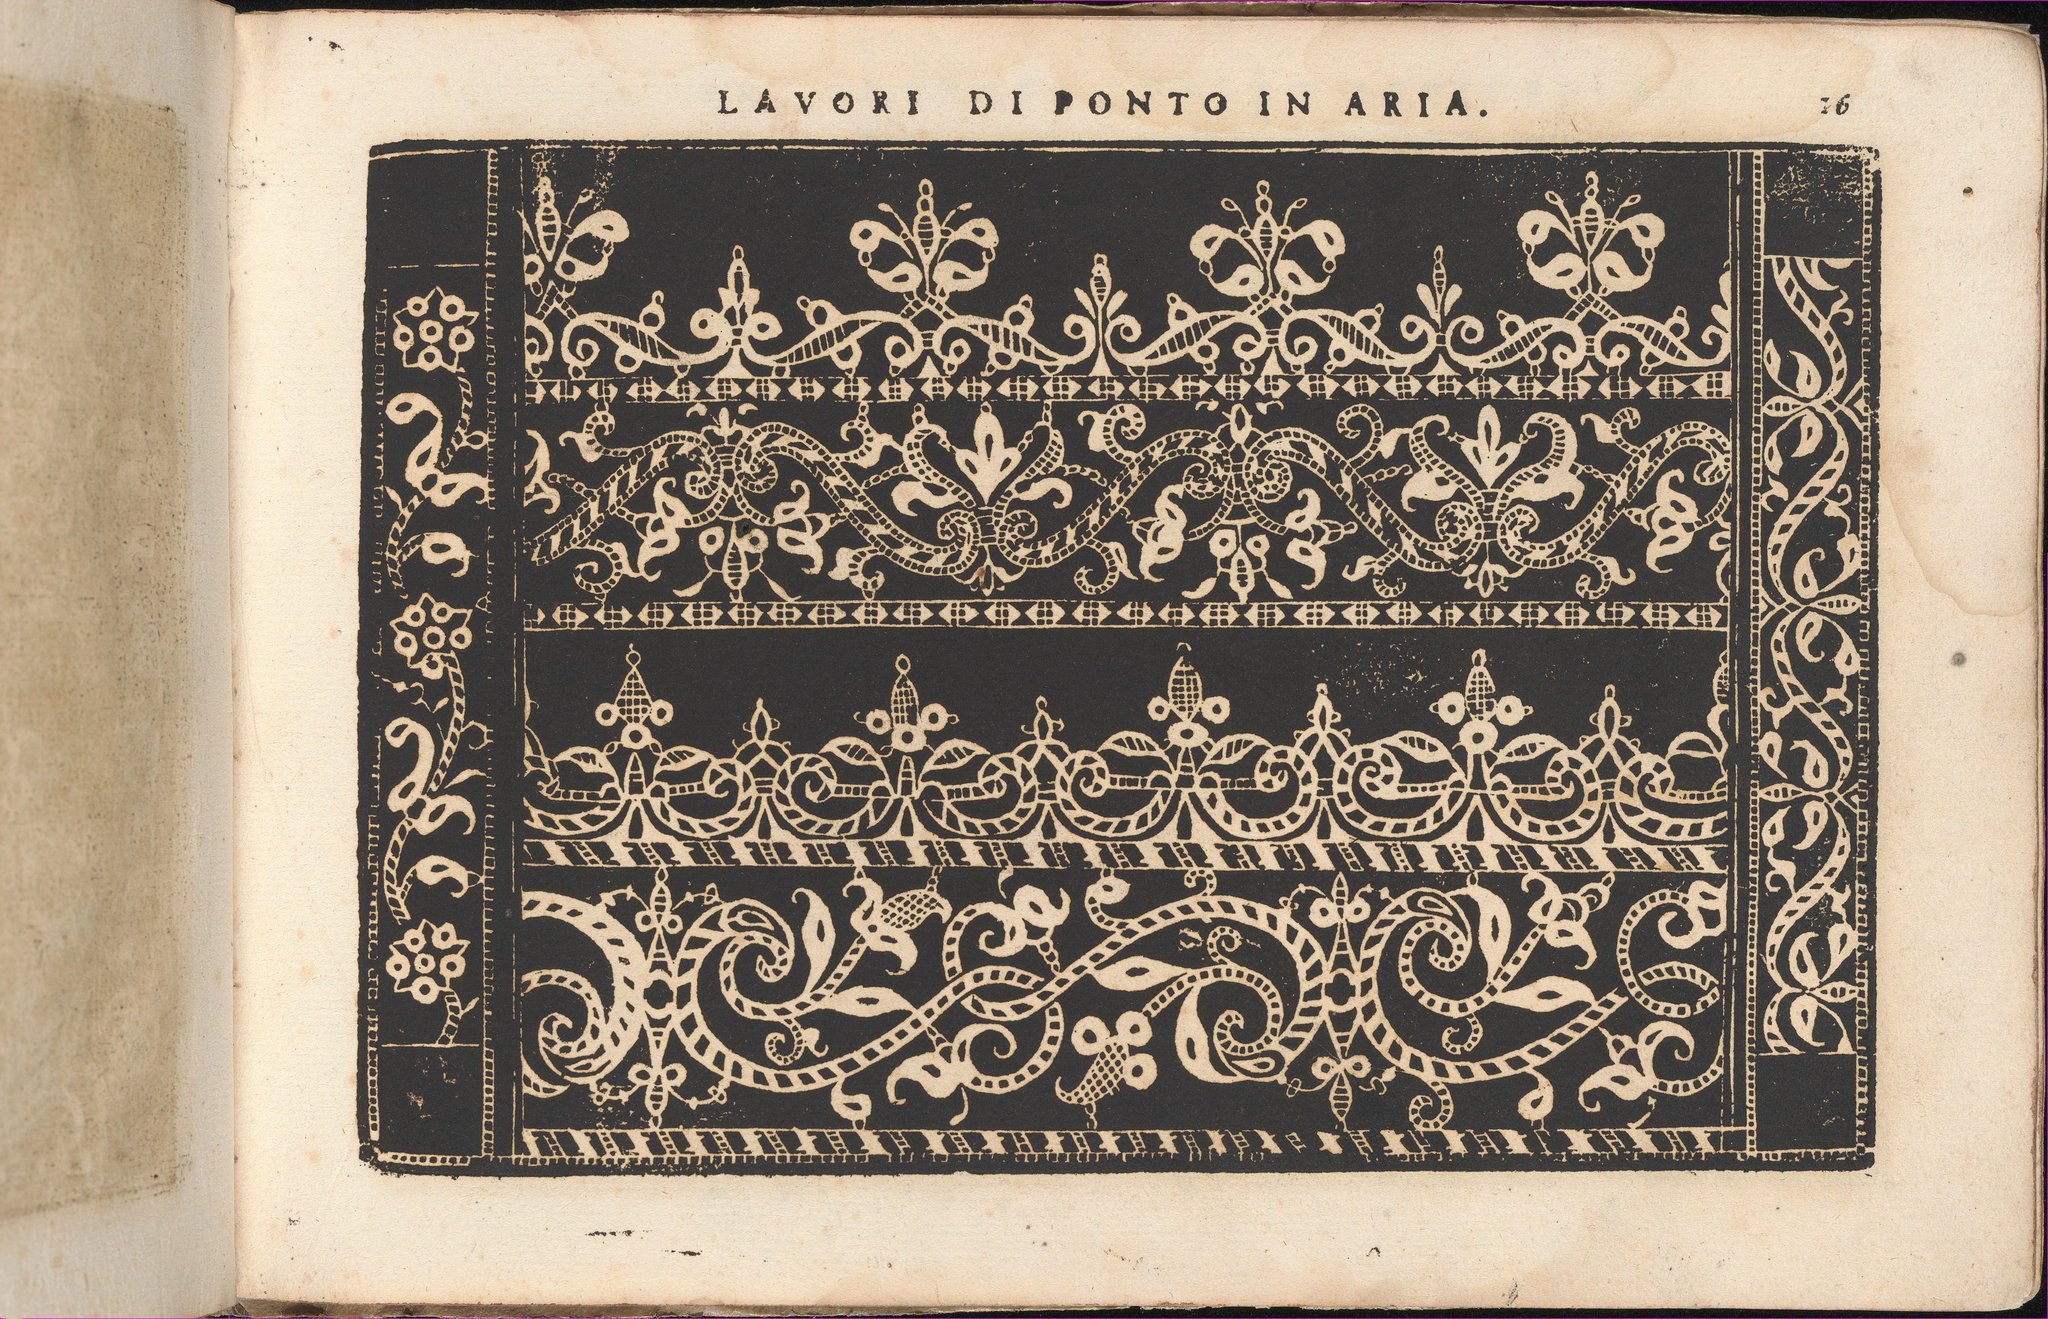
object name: book print ornament architecture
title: Teatro delle Nobili et Virtuose Donne..., page 24 (recto)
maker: isabella catanea parasole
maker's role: author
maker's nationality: italian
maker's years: 1565-1625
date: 1616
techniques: engraving, woodcut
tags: ornament